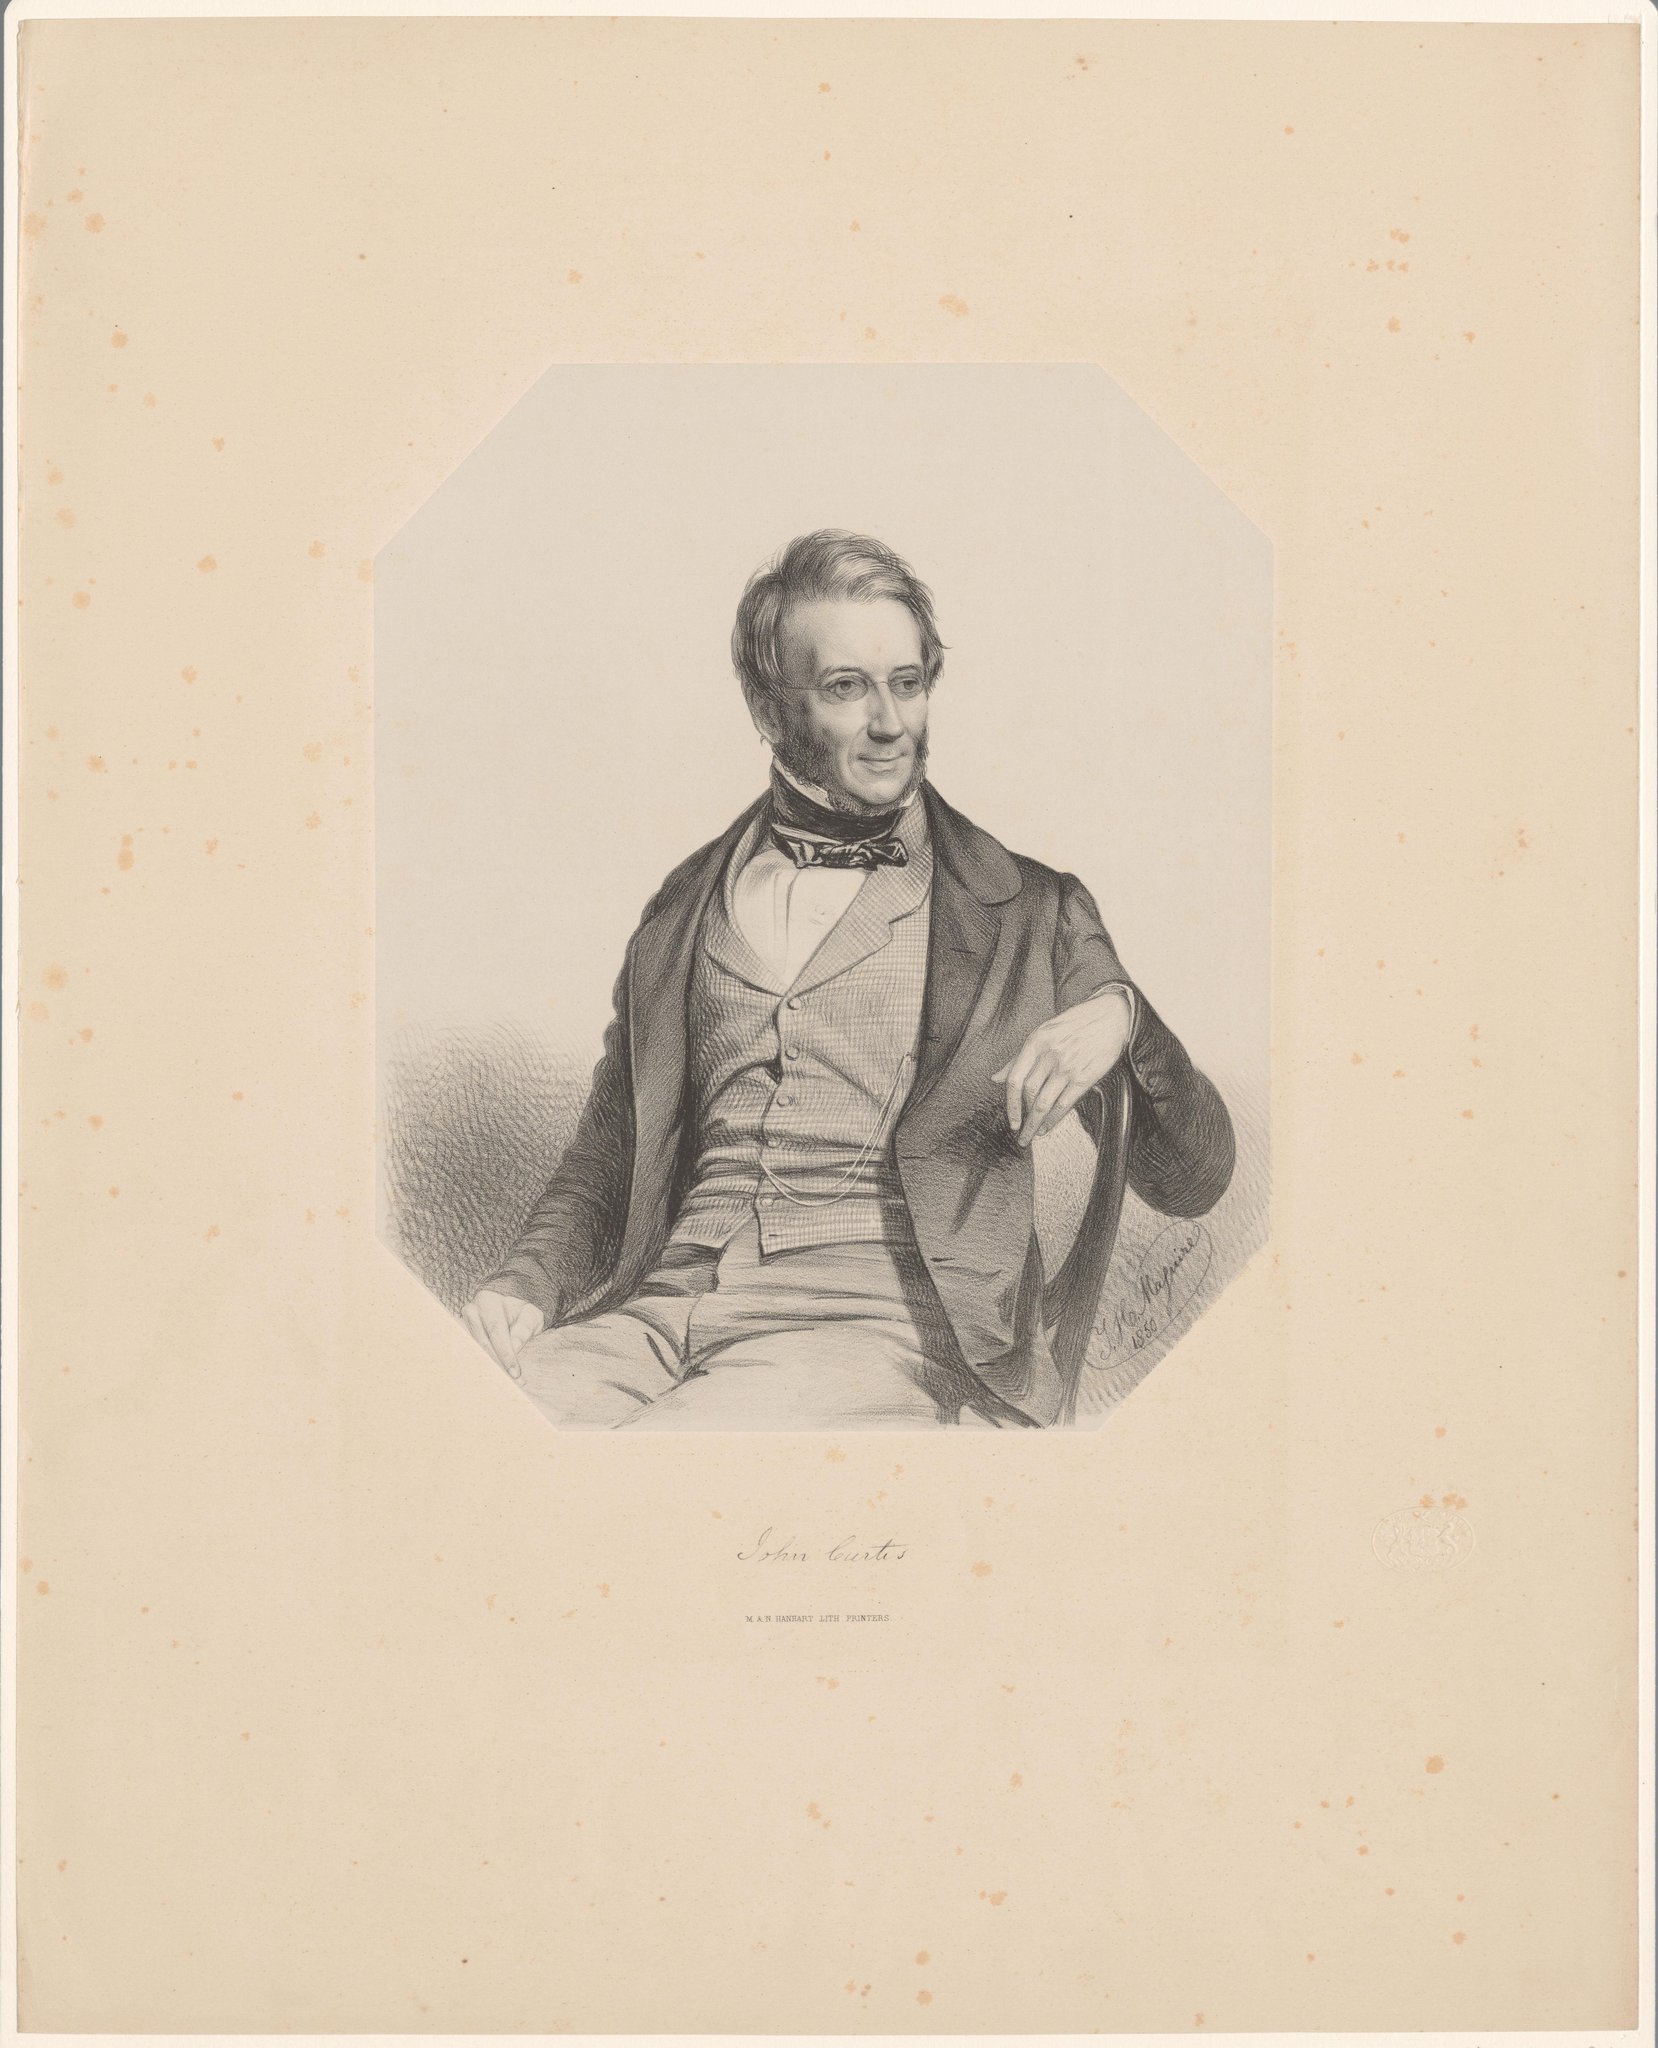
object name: print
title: Ipswich Museum Portraits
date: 1852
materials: paper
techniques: lithograph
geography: london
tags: adult man, historical persons, chair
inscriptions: check stamp: ‘Ipswich Museum’, collector's mark: Lugt 2228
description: Prent behoort tot de serie 'Ipswich Museum Portraits', ook bekend onder de titel 'Portraits of Honorary Members of the Ipswich Museum'. Deze serie is in 1852 door George Ransome uitgegeven en gedrukt door M&N Hanhart tussen 1848 en 1852. De serie bestaat uit ca. 60 portretten.